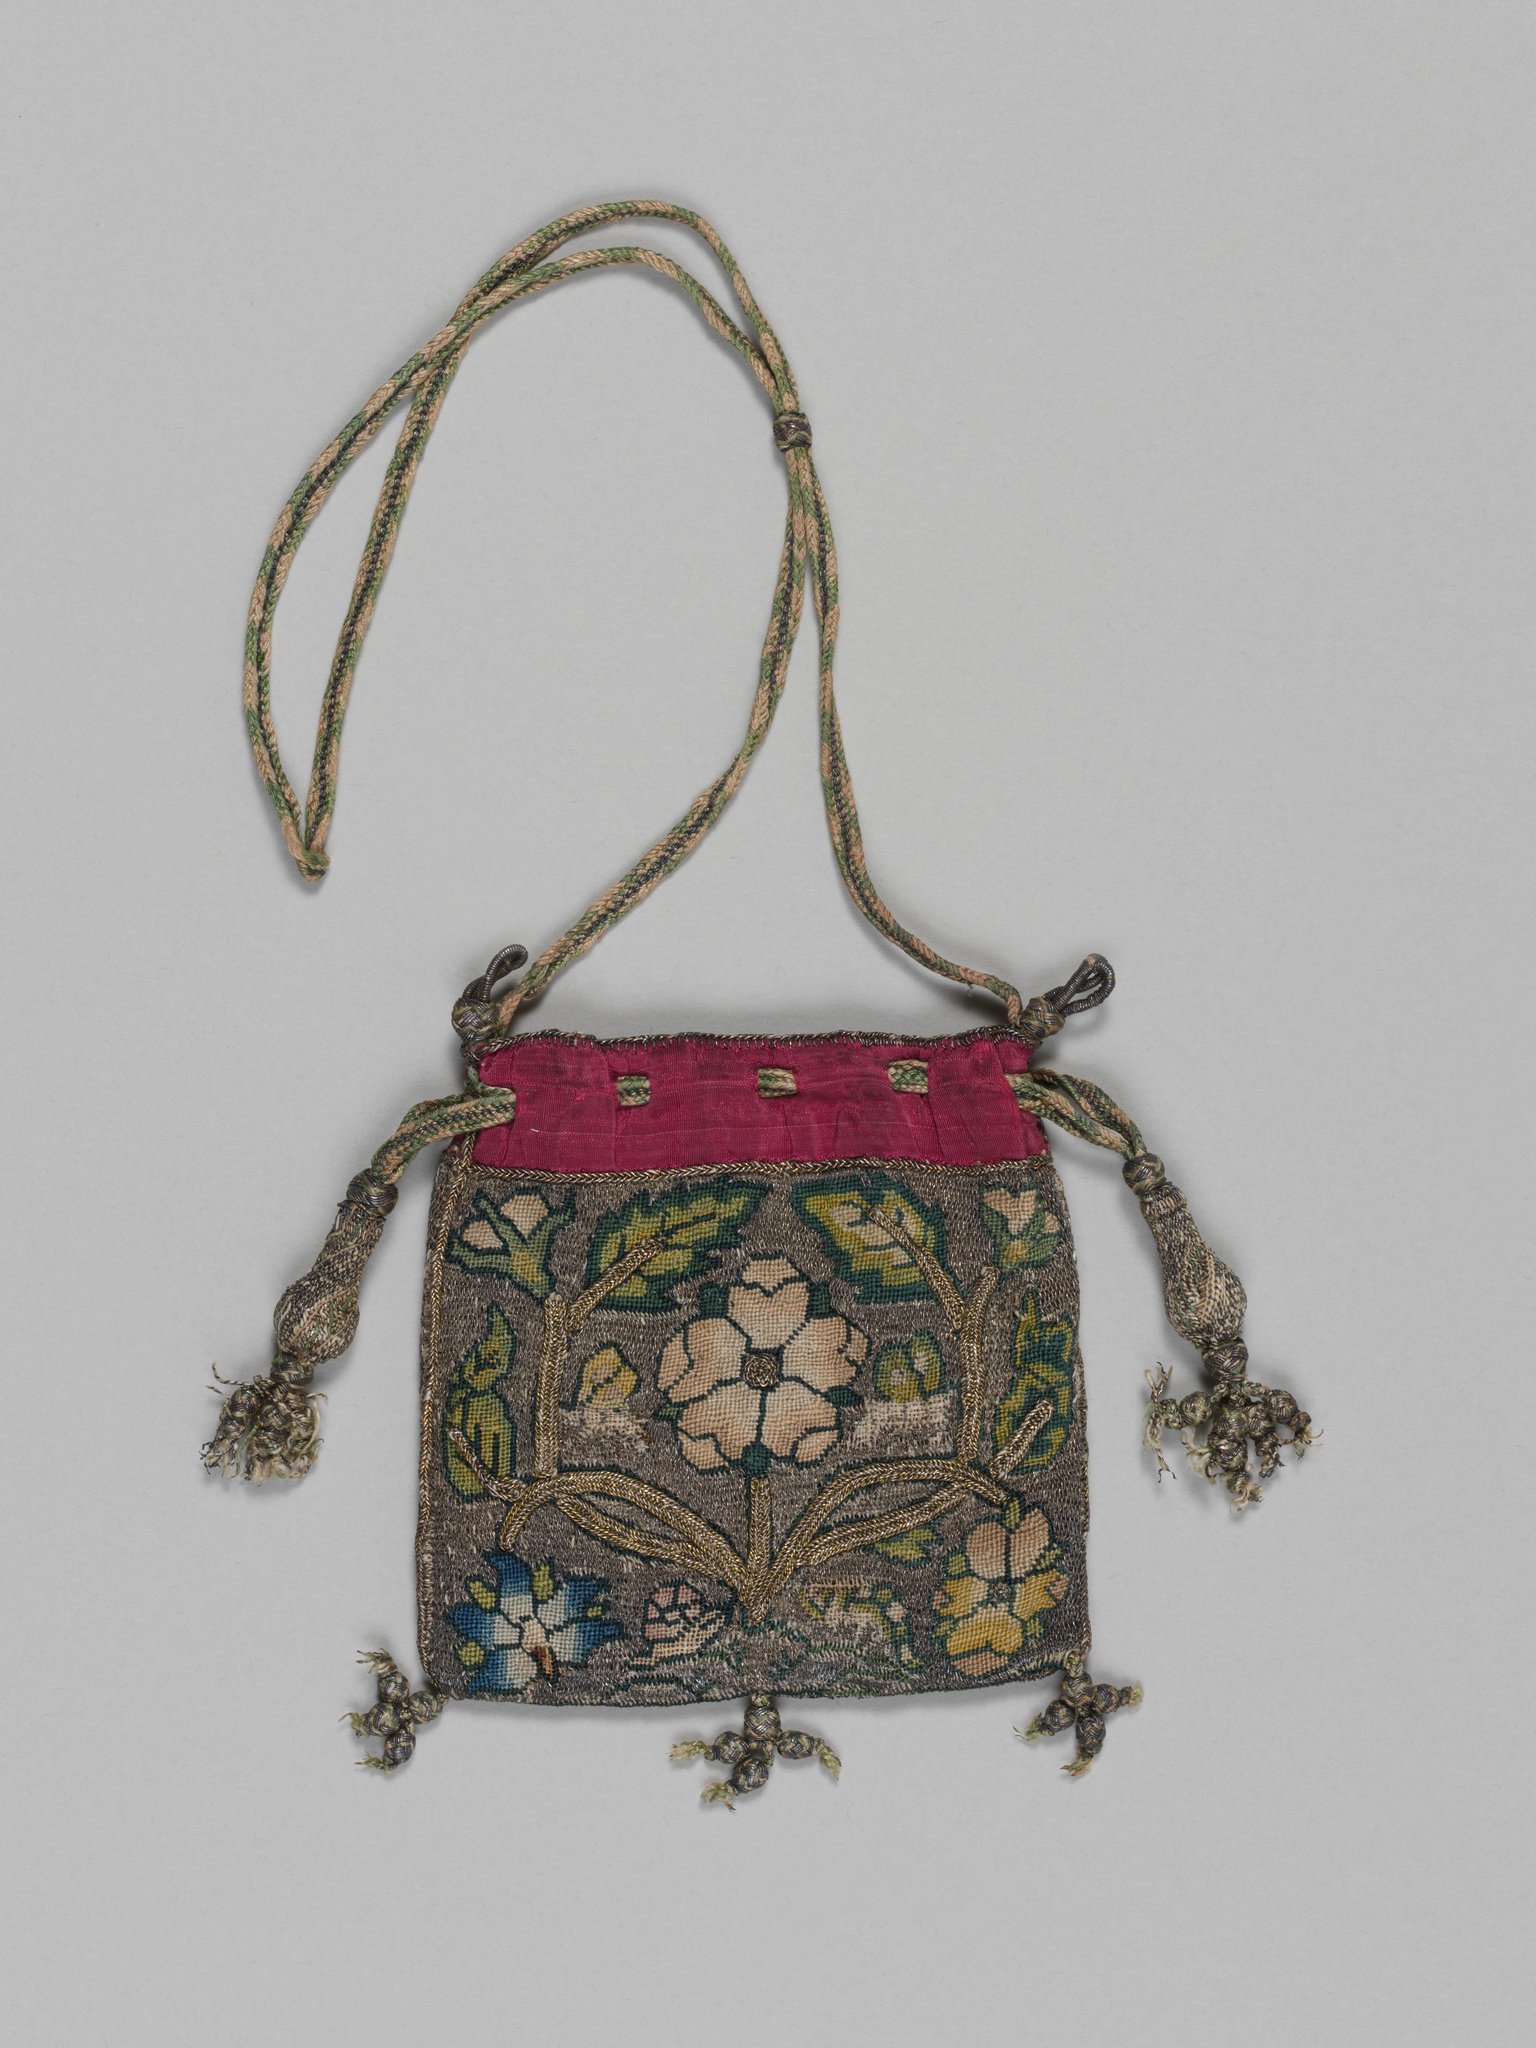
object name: bag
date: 1601-1633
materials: canvas, silk, thread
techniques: embroidery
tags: flowers